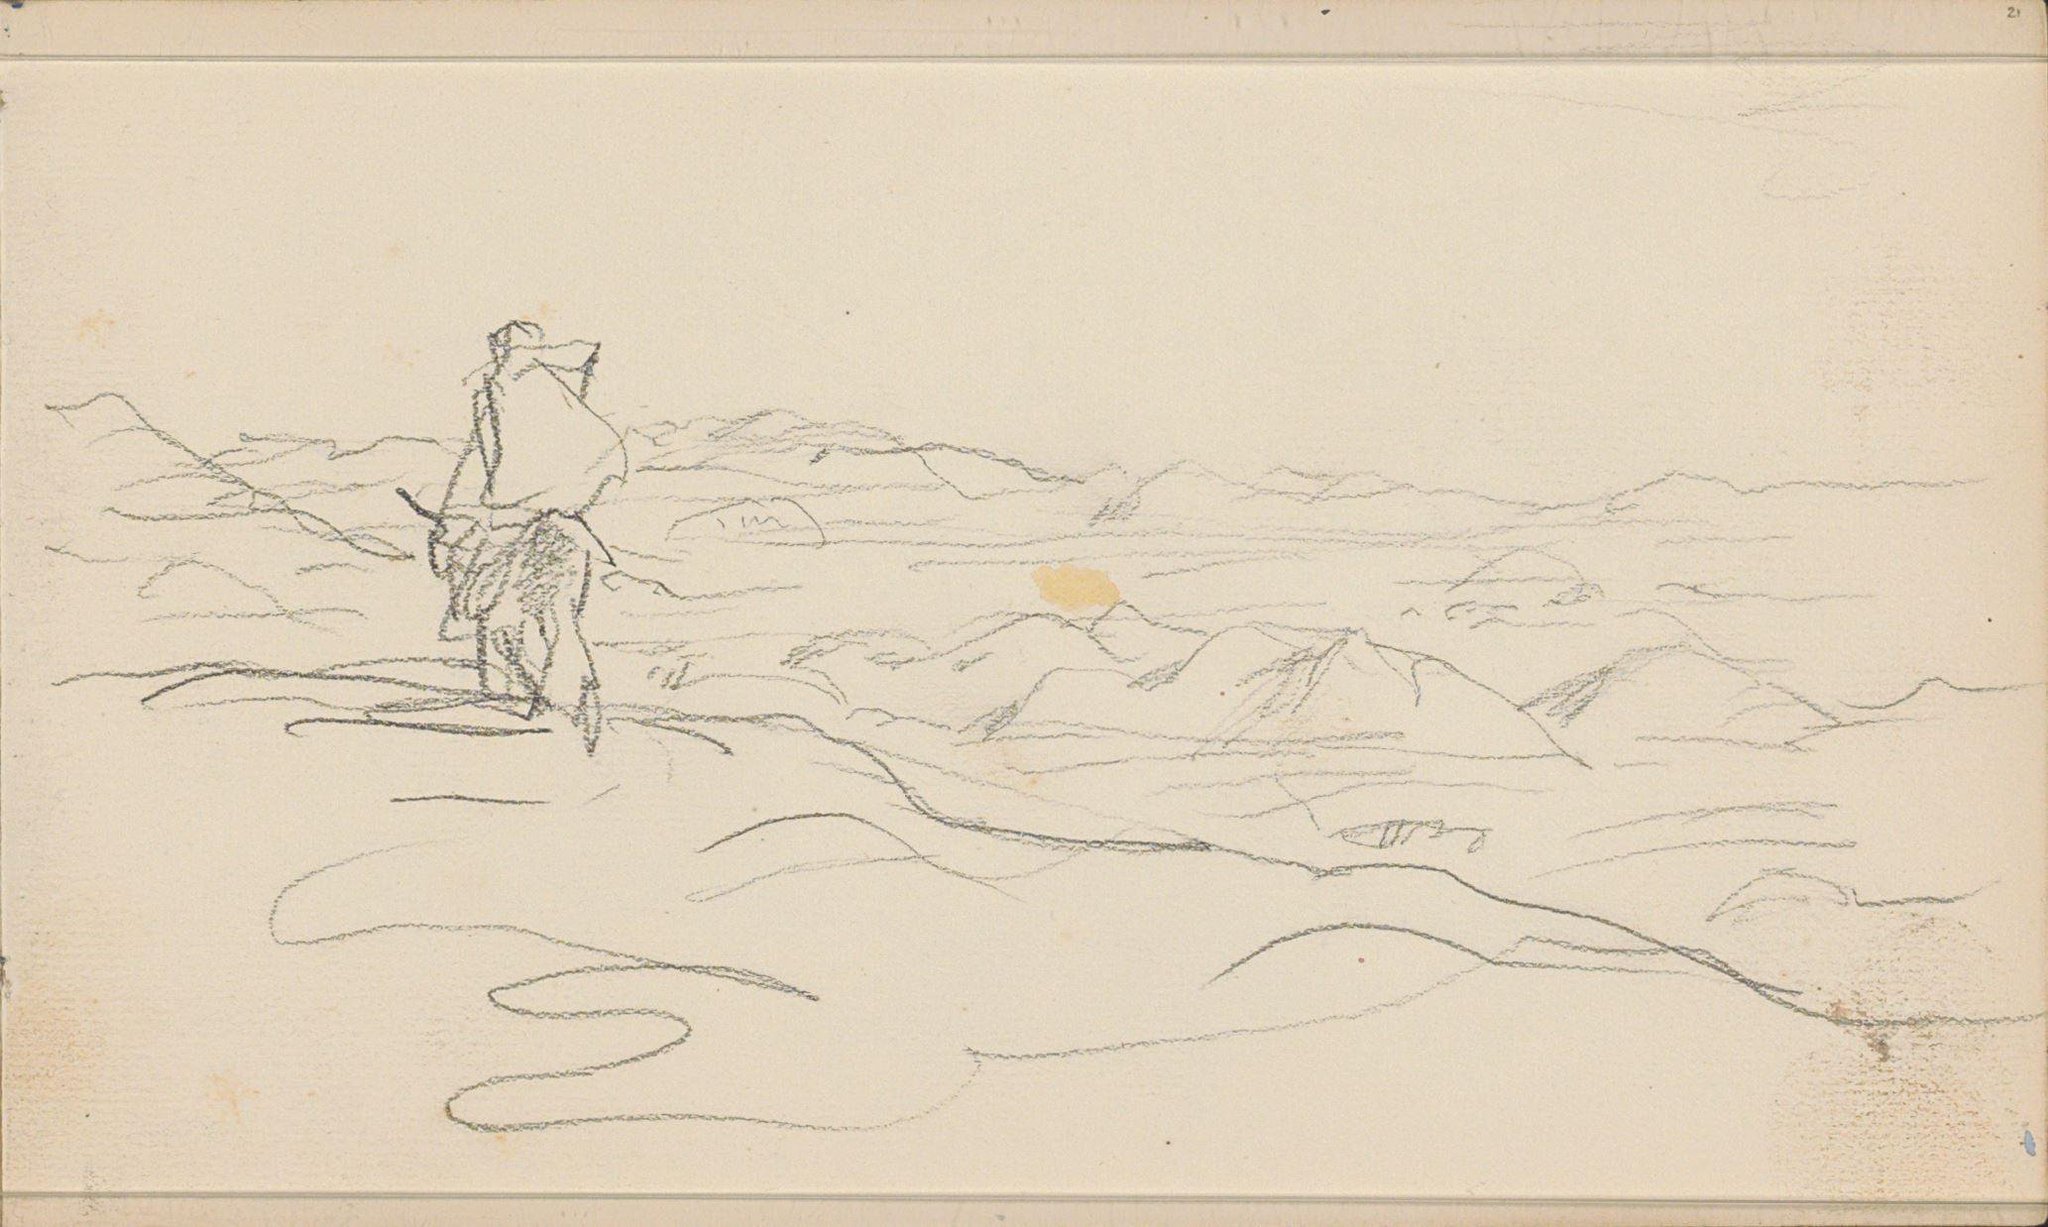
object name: sketchbook leaf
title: Woestijnlandschap met een figuur op een ezel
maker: marius bauer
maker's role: draughtsman, print maker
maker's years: 1867-1932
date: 1922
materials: paper, pencil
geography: algeria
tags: riding a horse, ass, or mule; rider, horseman, desert, landscapes (+ landscape with figures, staffage)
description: Pagina 21 uit een schetsboek met 31 bladen.